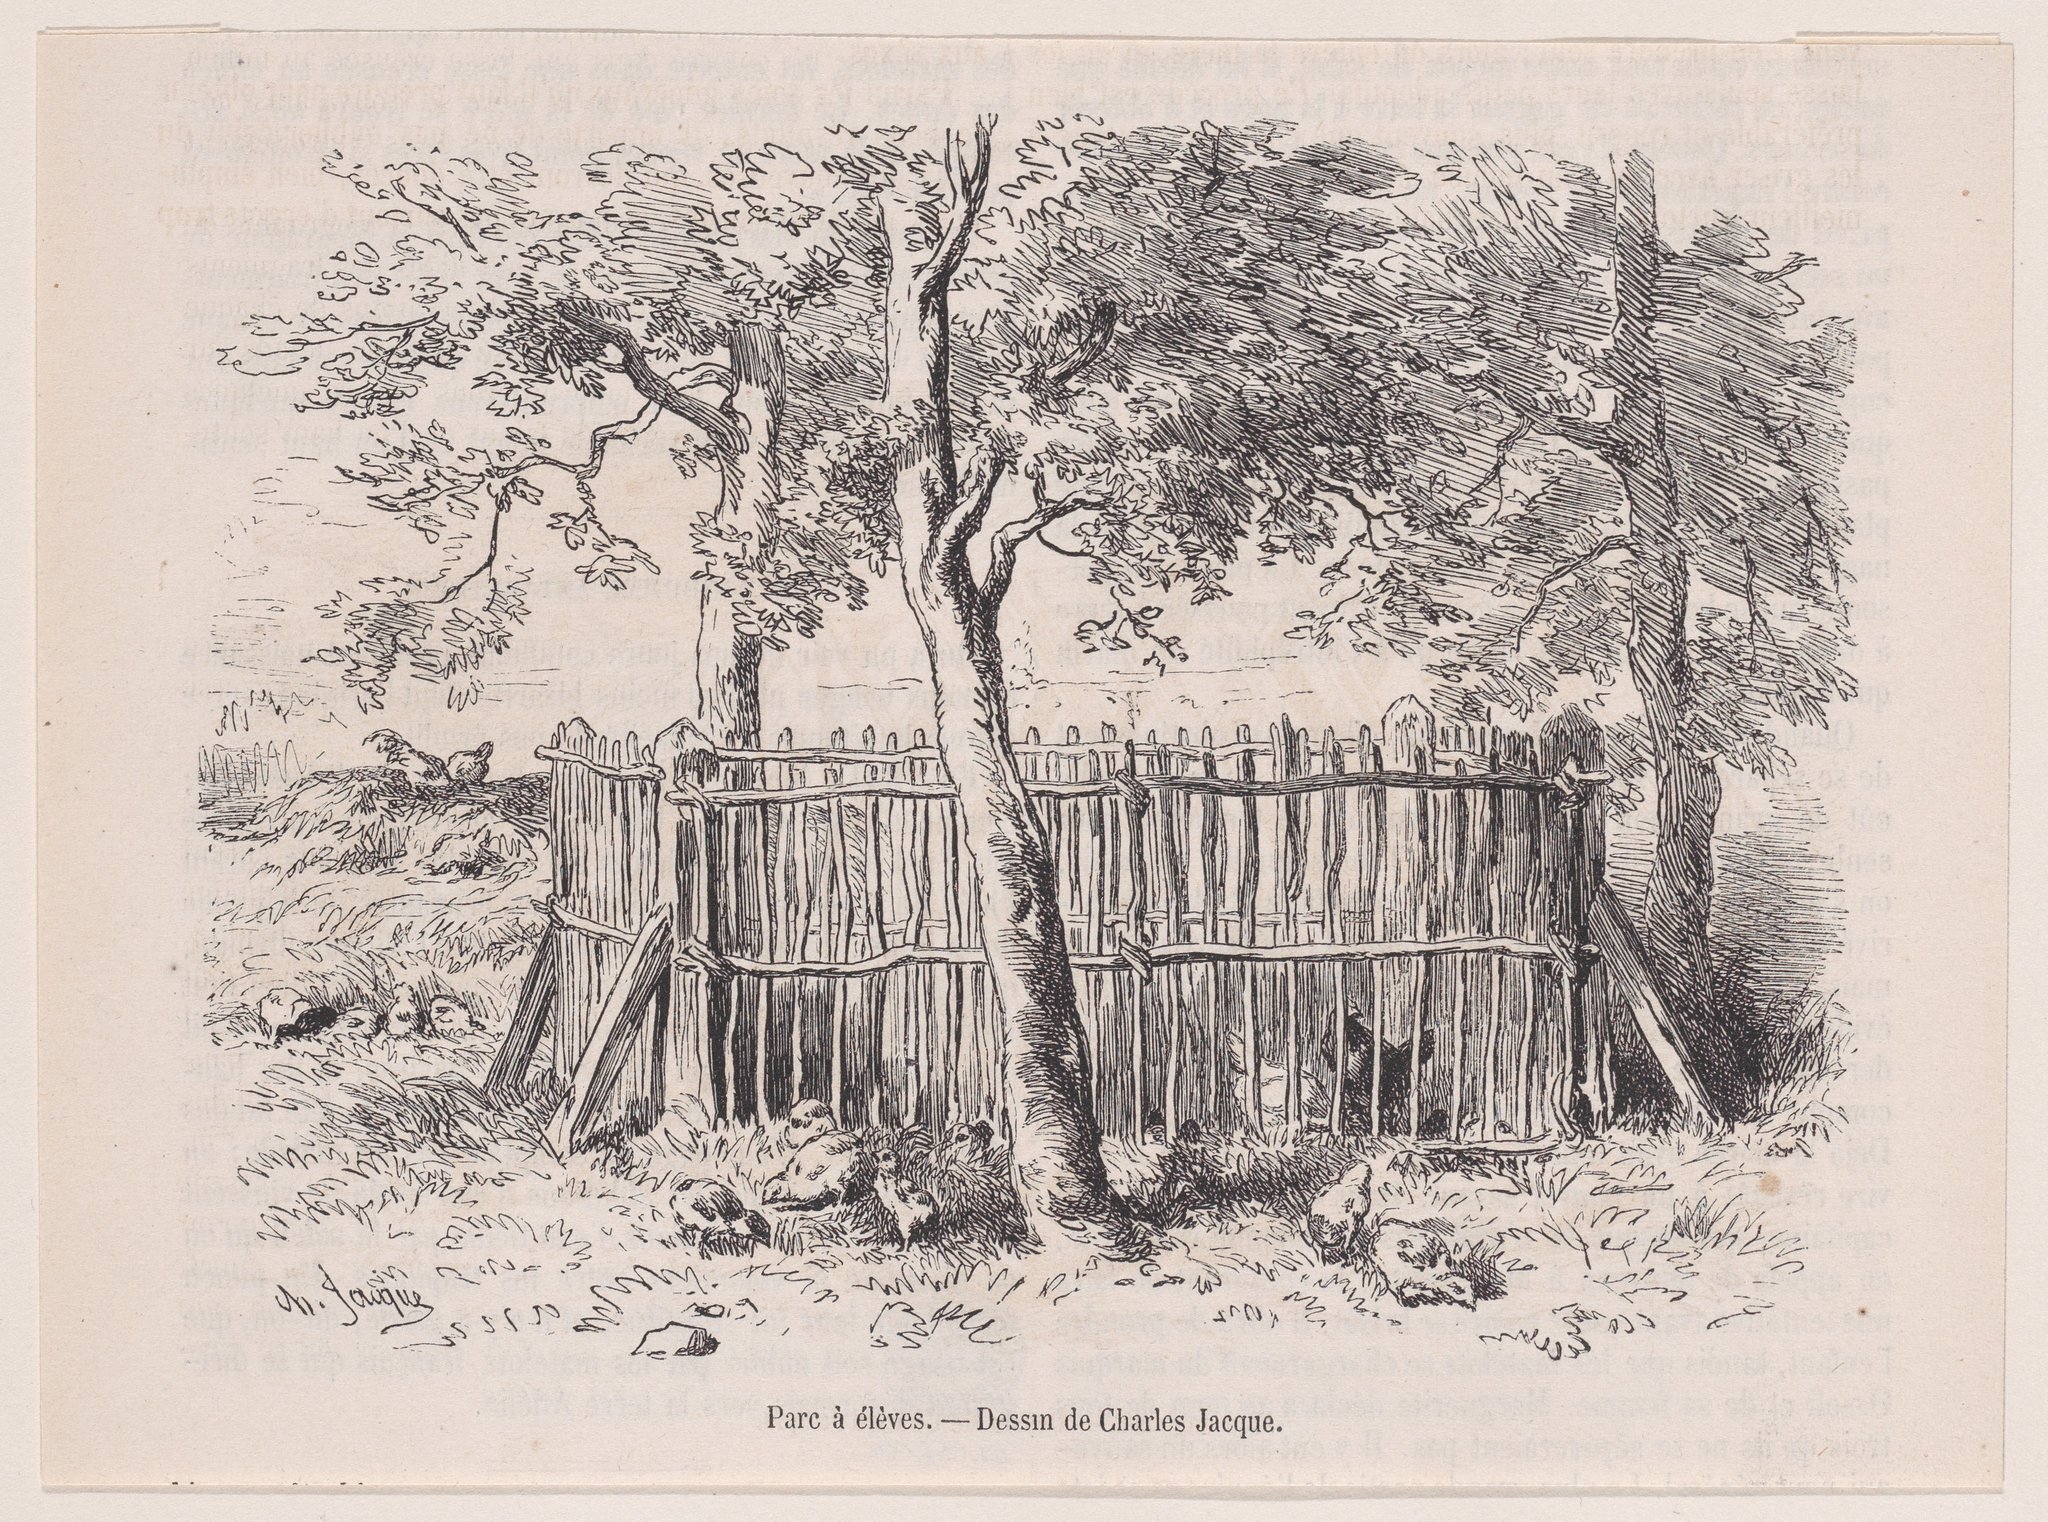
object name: print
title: Parc à élèves, from "Le Magasin Pittoresque"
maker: charles émile jacque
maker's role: artist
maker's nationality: french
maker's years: 1813-1894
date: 1852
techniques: engraving